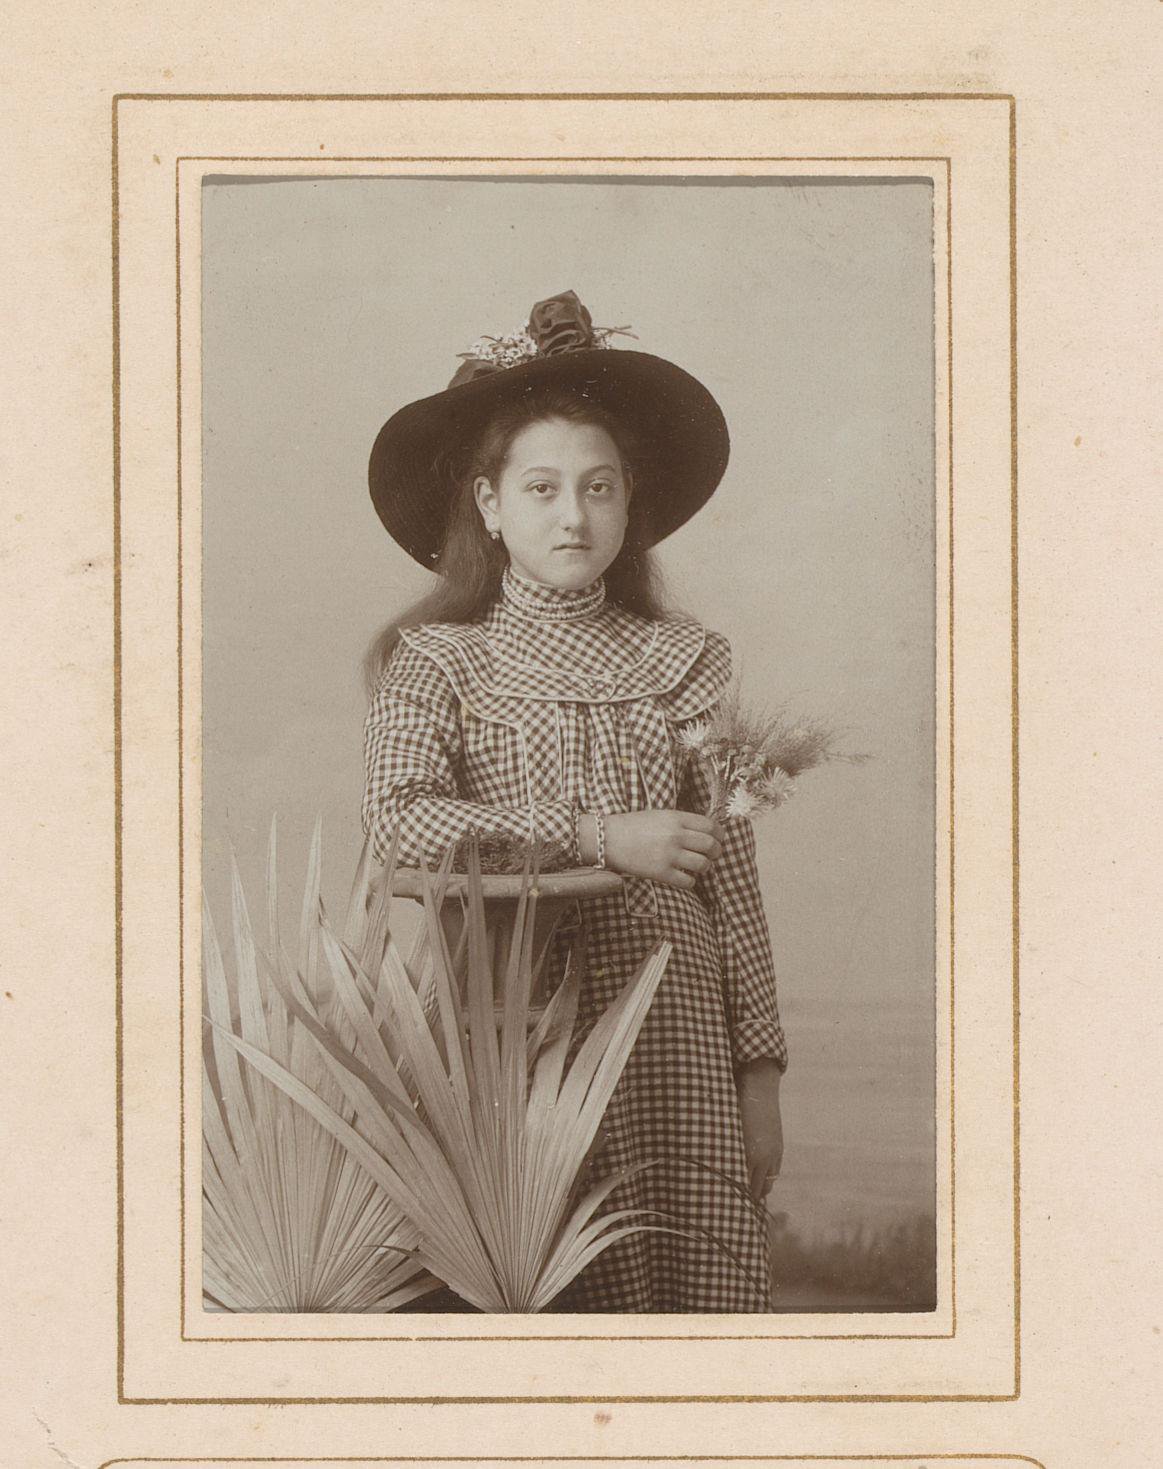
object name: cabinet photograph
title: Portret van een meisje met hoed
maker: wilhelm frederick antonius delboy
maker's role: fotograaf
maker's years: 1853-1928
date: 1887-1928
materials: cardboard, photographic support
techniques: collodion silver print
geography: the hague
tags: girl (child between toddler and youth), head-gear: hat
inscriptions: inscription: ‘Delboy/ Passage 22/ Den Haag’